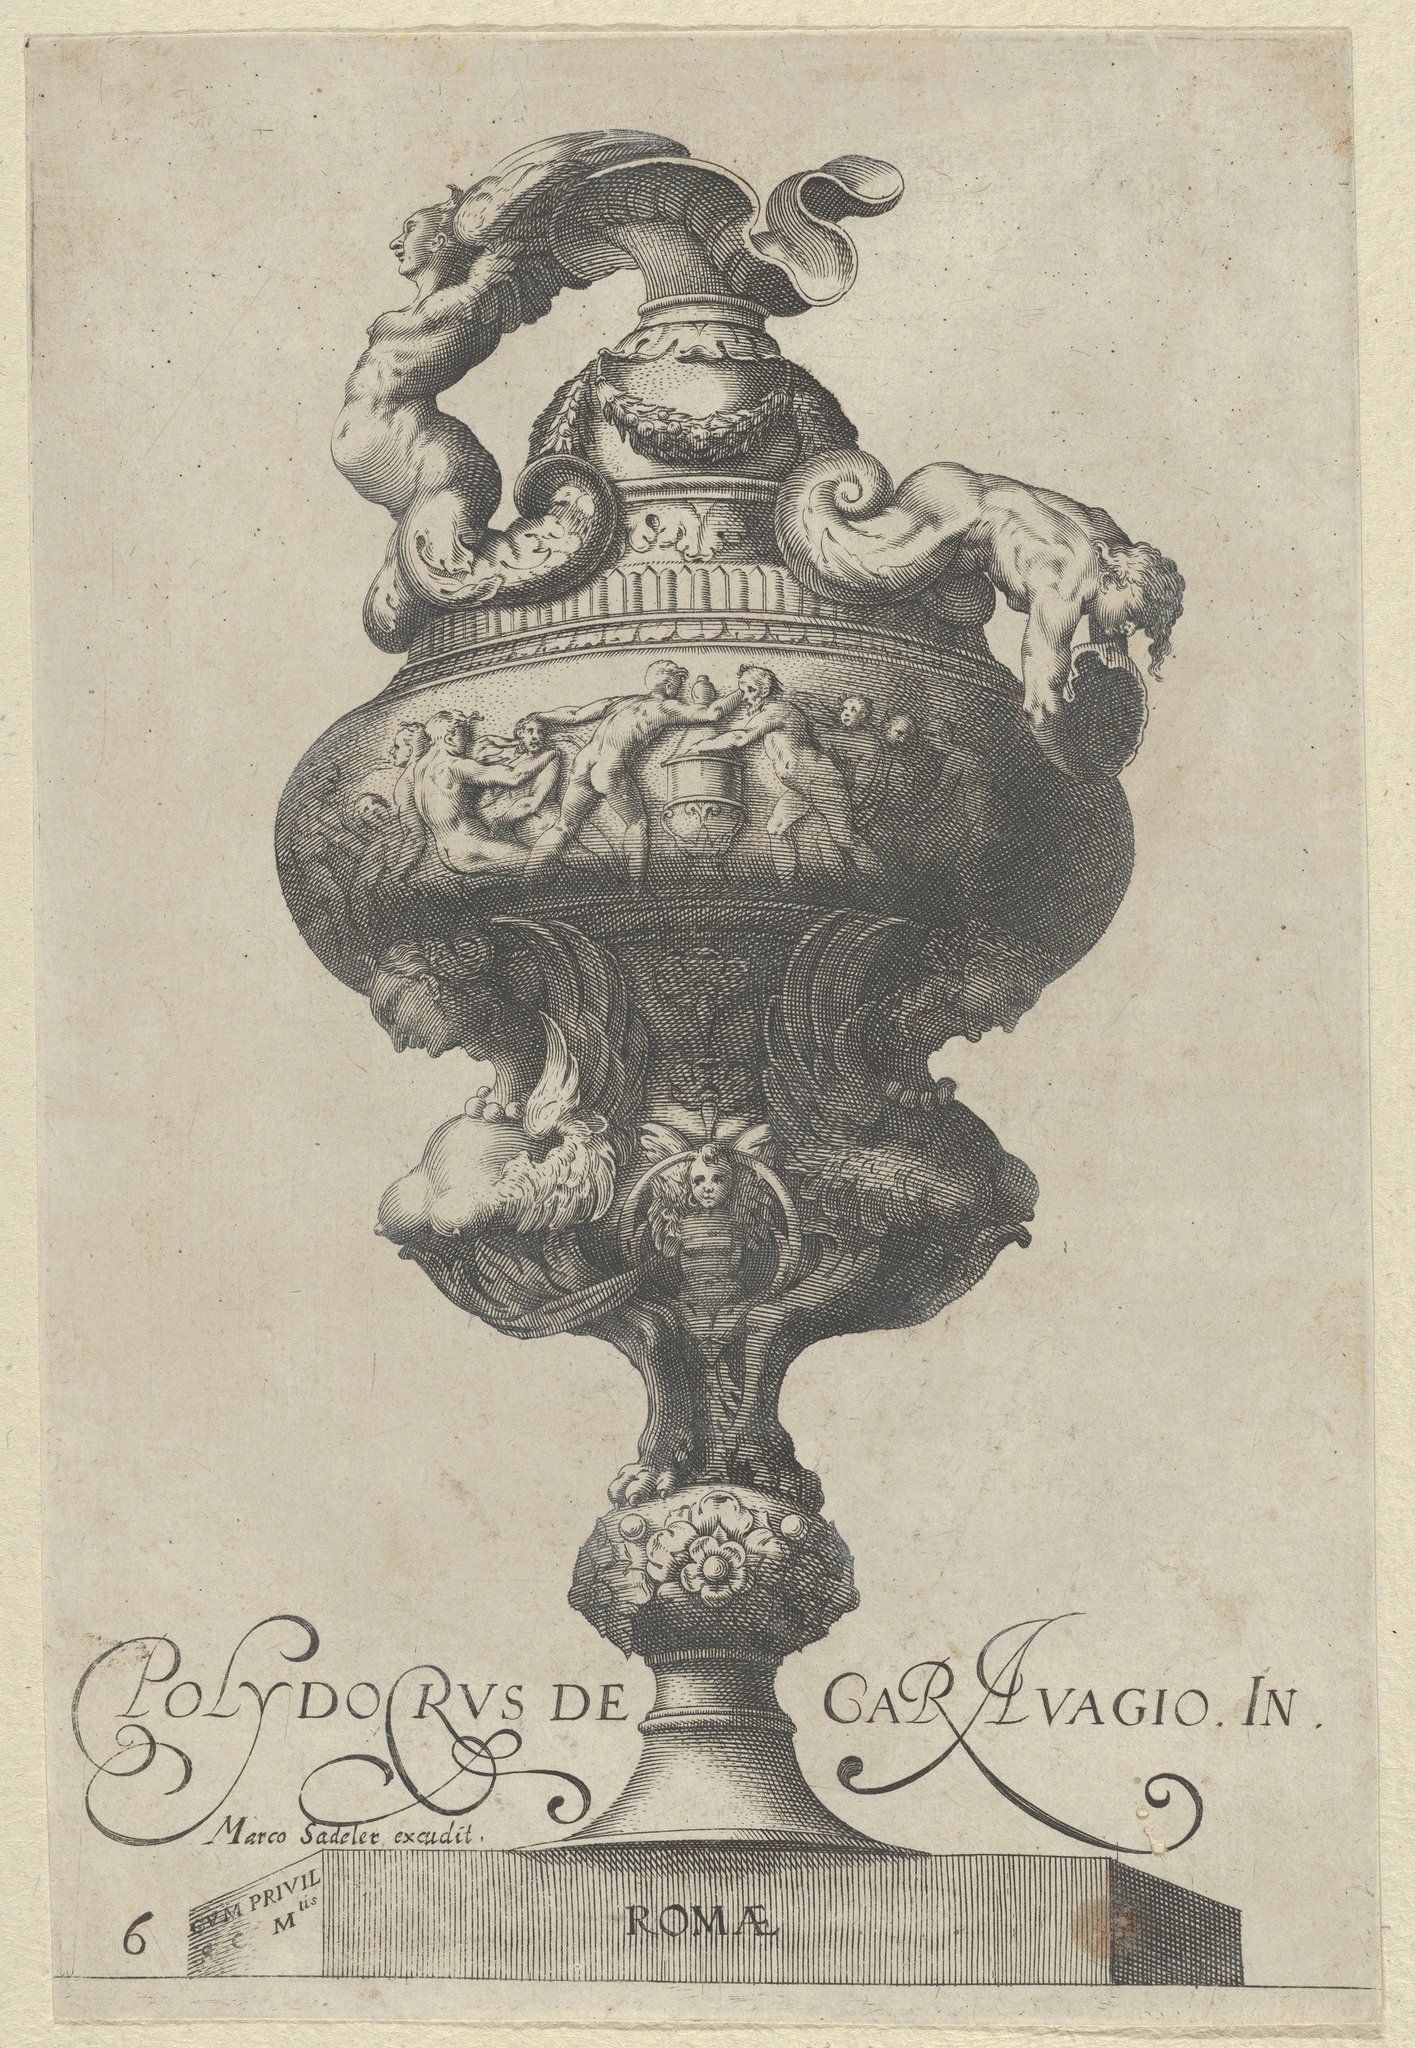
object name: print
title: Plate 6: Vase or Ewer with a Frieze Containing Naked Figures, Supported Below by Two Female Sphinxes, from "Antique Vases" (Vasa a Polydoro Caravagino)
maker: aegidius sadeler (ii)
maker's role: artist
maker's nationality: flemish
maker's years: 1568-1629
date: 1605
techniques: engraving, etching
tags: male nudes,sphinx,ewers